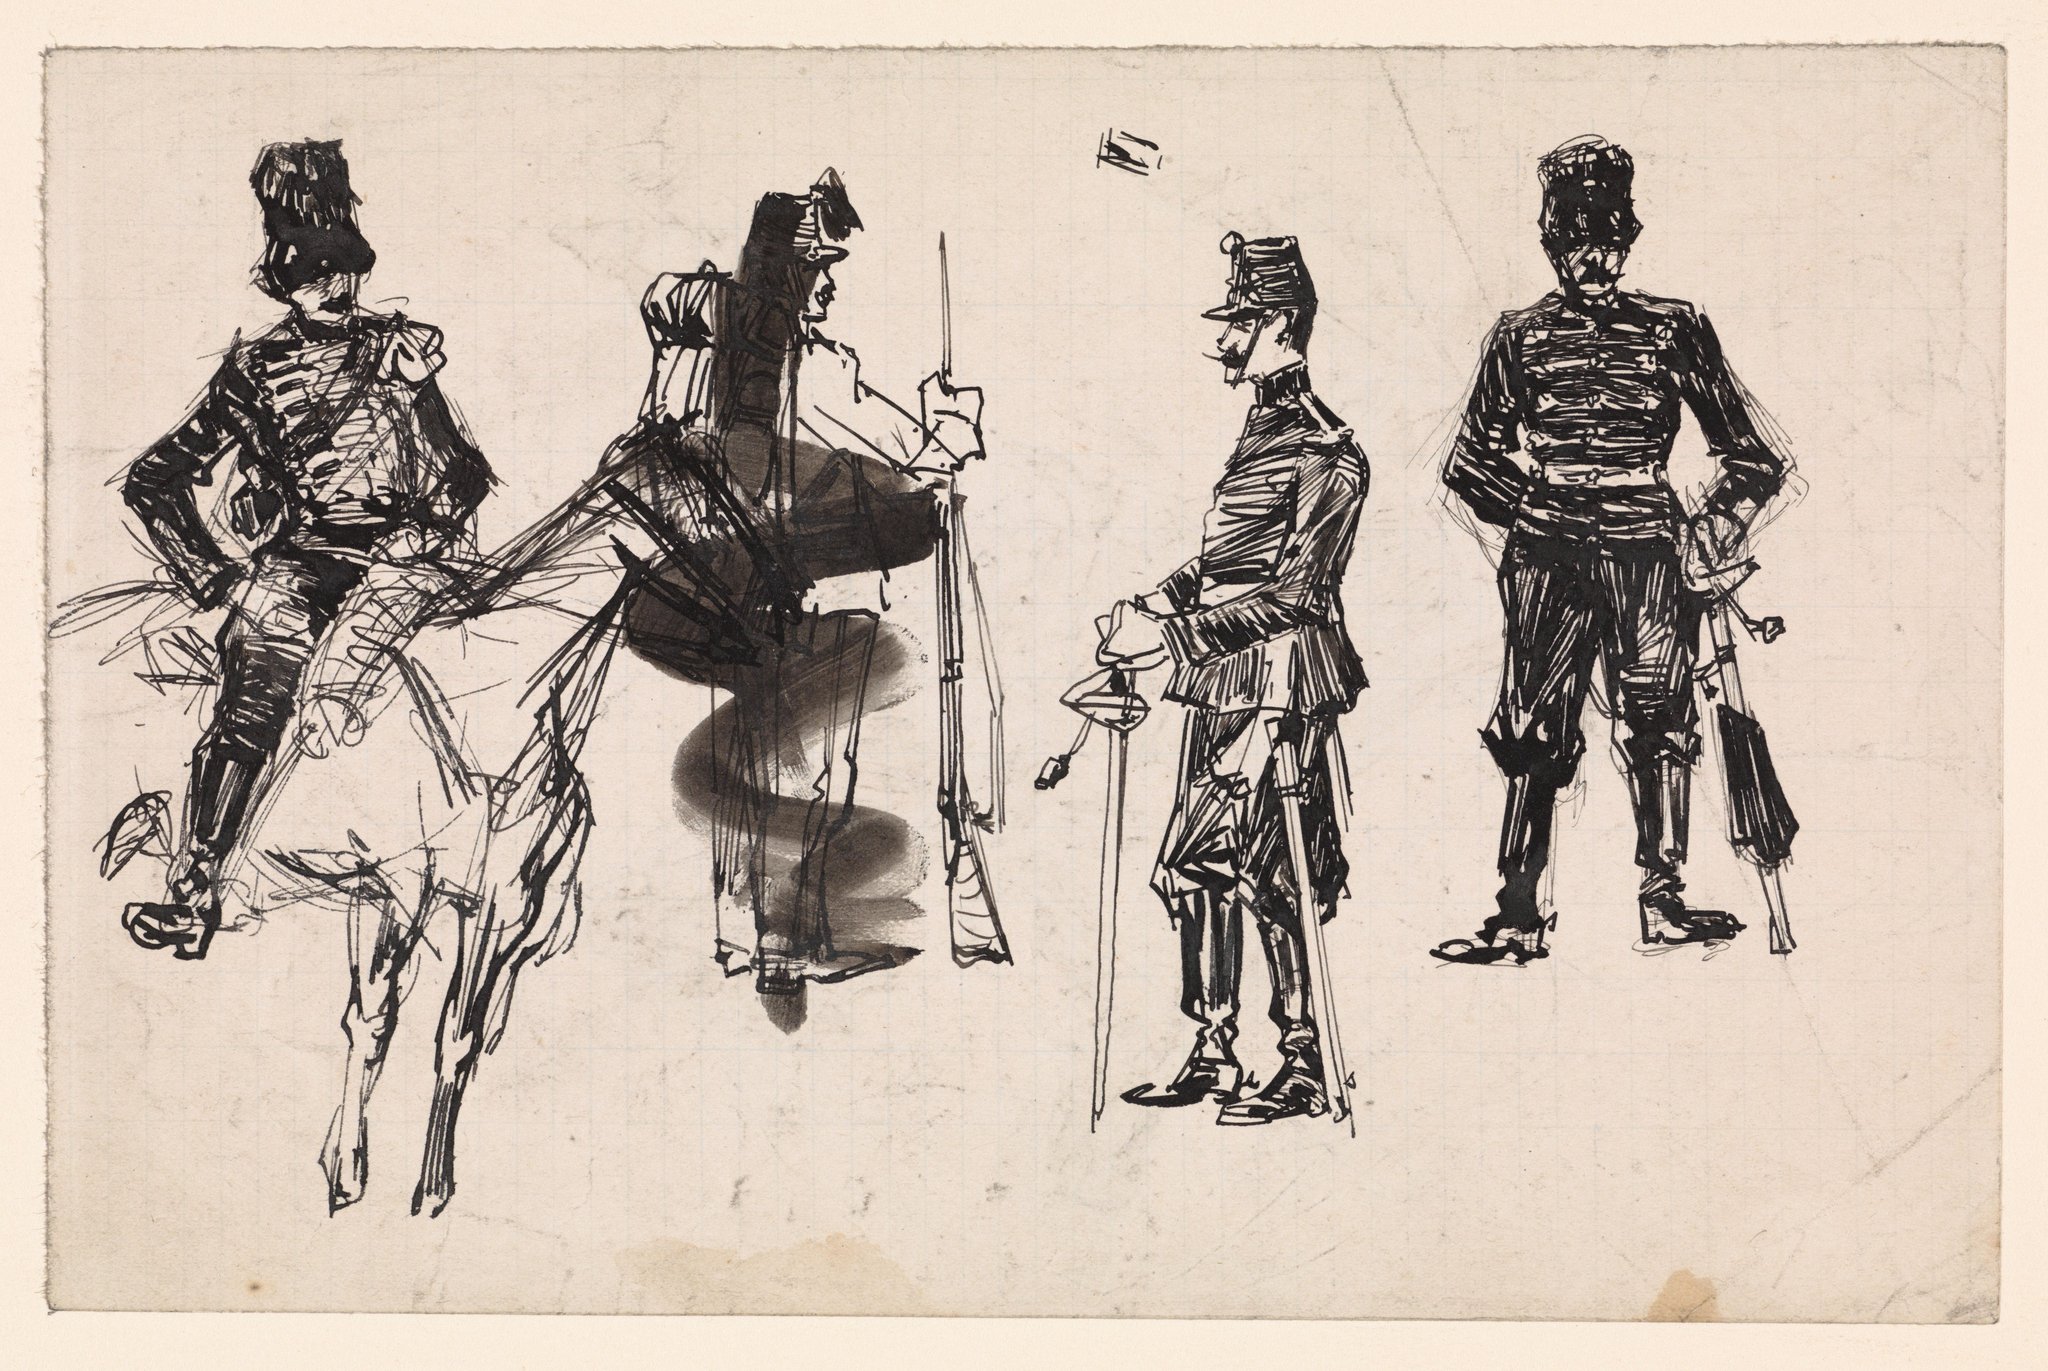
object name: drawing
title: Studies van huzaren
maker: edzard koning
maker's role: draughtsman, print maker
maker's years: 1869-1954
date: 1879-1954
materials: ink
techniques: pen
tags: private soldier (+ cavalry, horsemen)